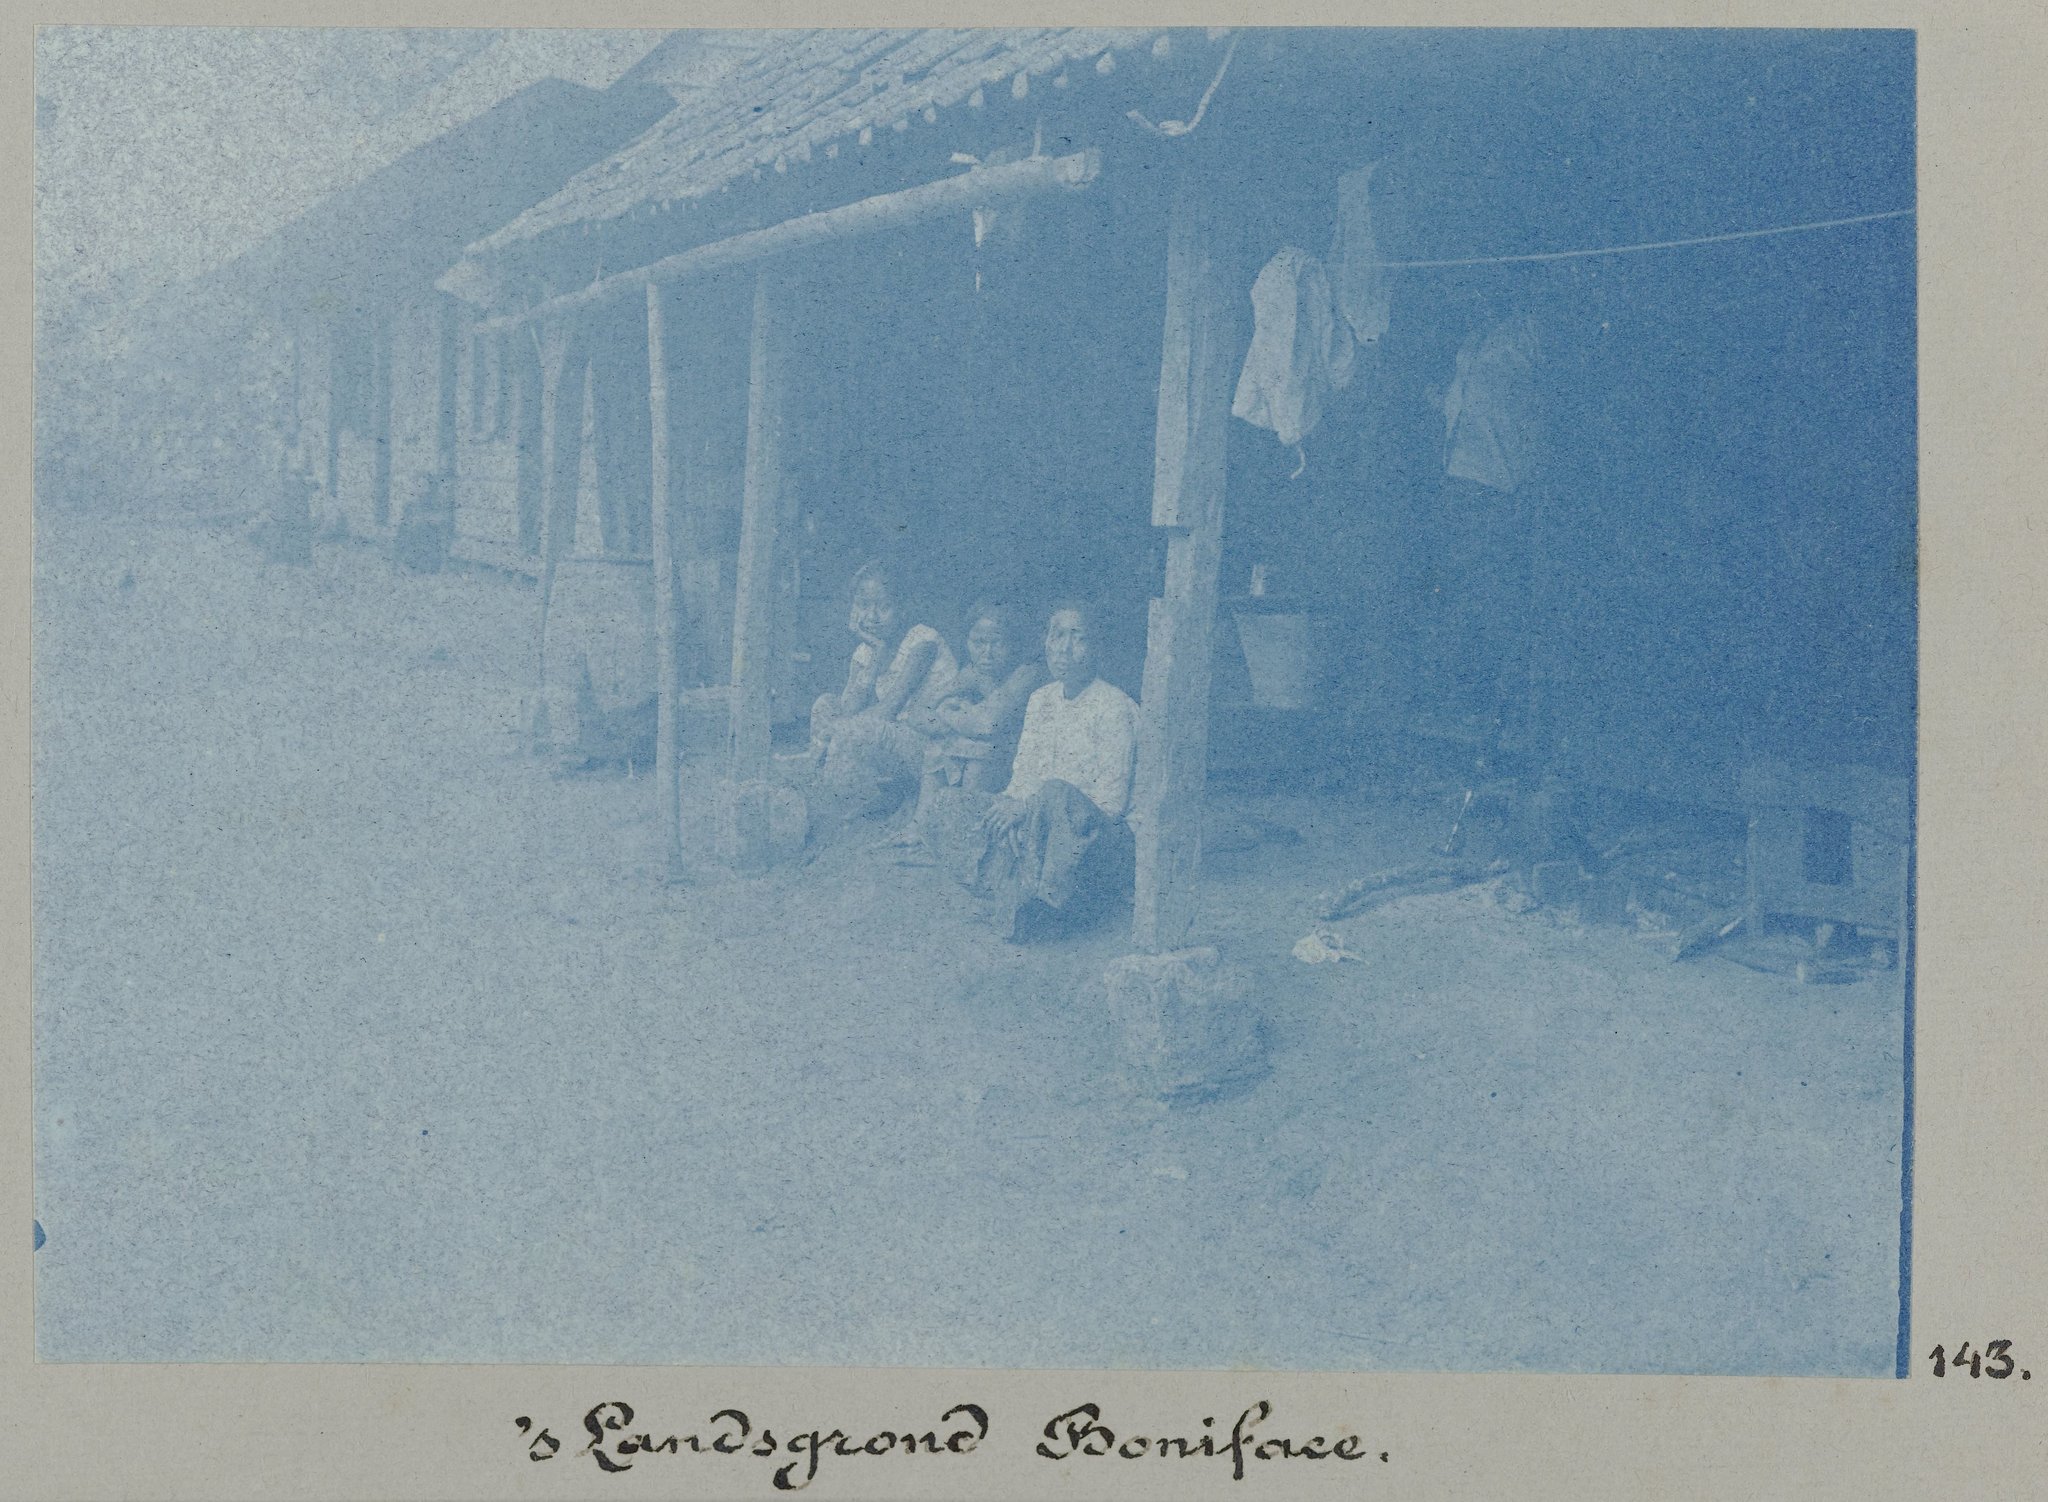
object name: photograph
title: 's Landsgrond Boniface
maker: hendrik doijer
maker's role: engineer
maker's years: 1863-1925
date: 1903-1910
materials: photographic support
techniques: cyanotype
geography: suriname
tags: suriname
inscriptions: inscription: ‘143. / 's Landsgrond Boniface.’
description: Drie vrouwen zittend voor een woning in het bejaardenhuis of weldadigheidsgesticht op 's-Landsgrond Boniface te Paramaribo. Onderdeel van het fotoalbum Souvenir de Voyage (deel 5), over het leven van de familie Doijer in en rond de plantage Ma Retraite in Suriname in de jaren 1903-1910.